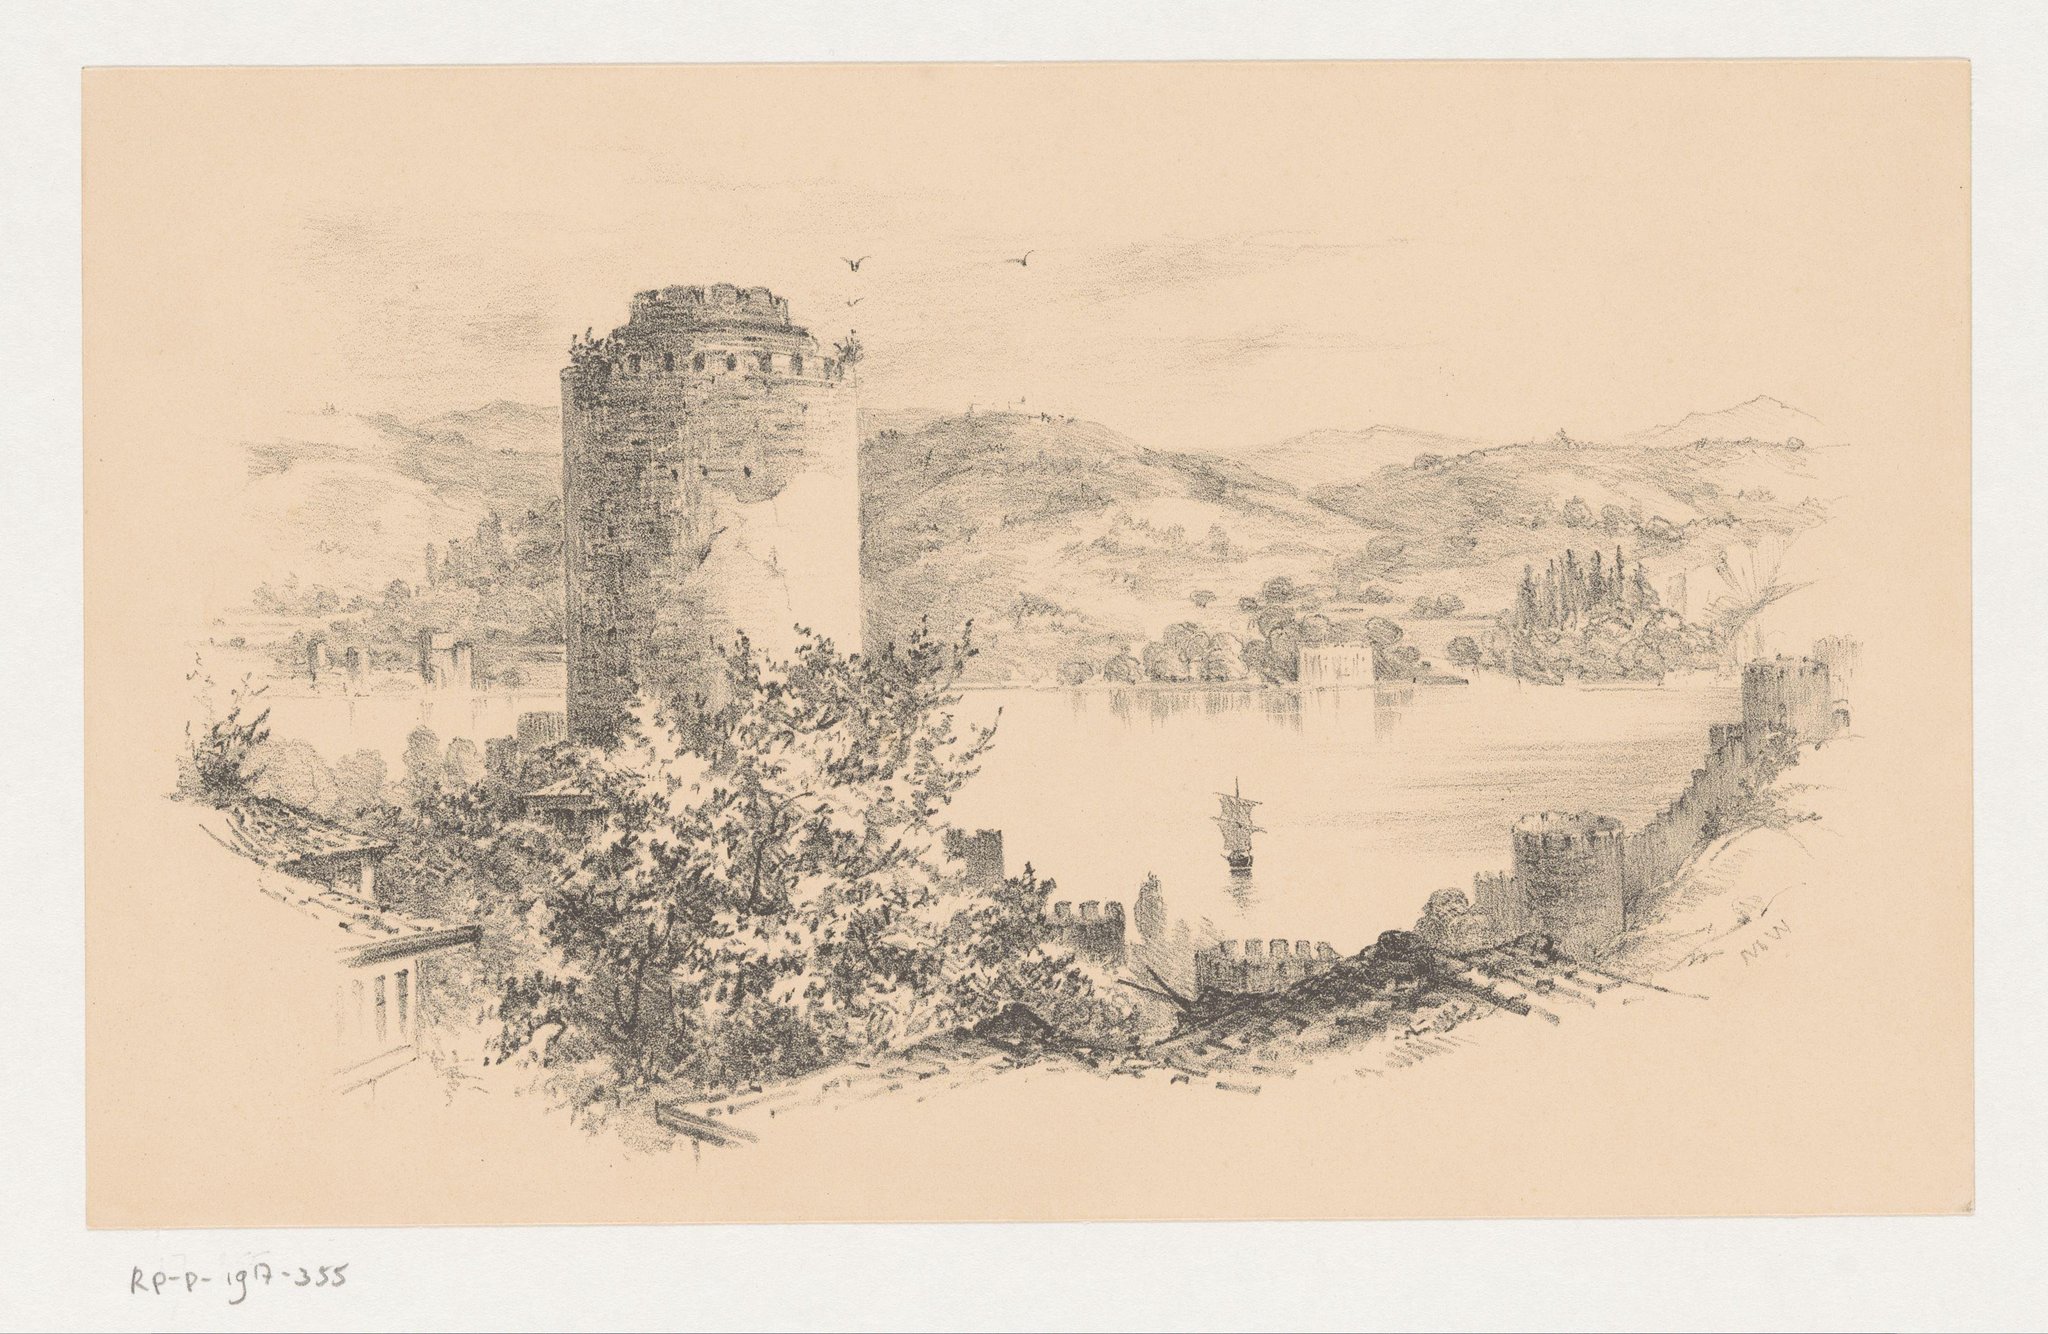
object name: print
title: Gezicht op de Bosporus met op de voorgrond een ronde toren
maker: Anonymous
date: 1800-1900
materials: paper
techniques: lithograph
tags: landscapes, river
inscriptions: collector's mark: Lugt 2228, monogram: ‘MW’